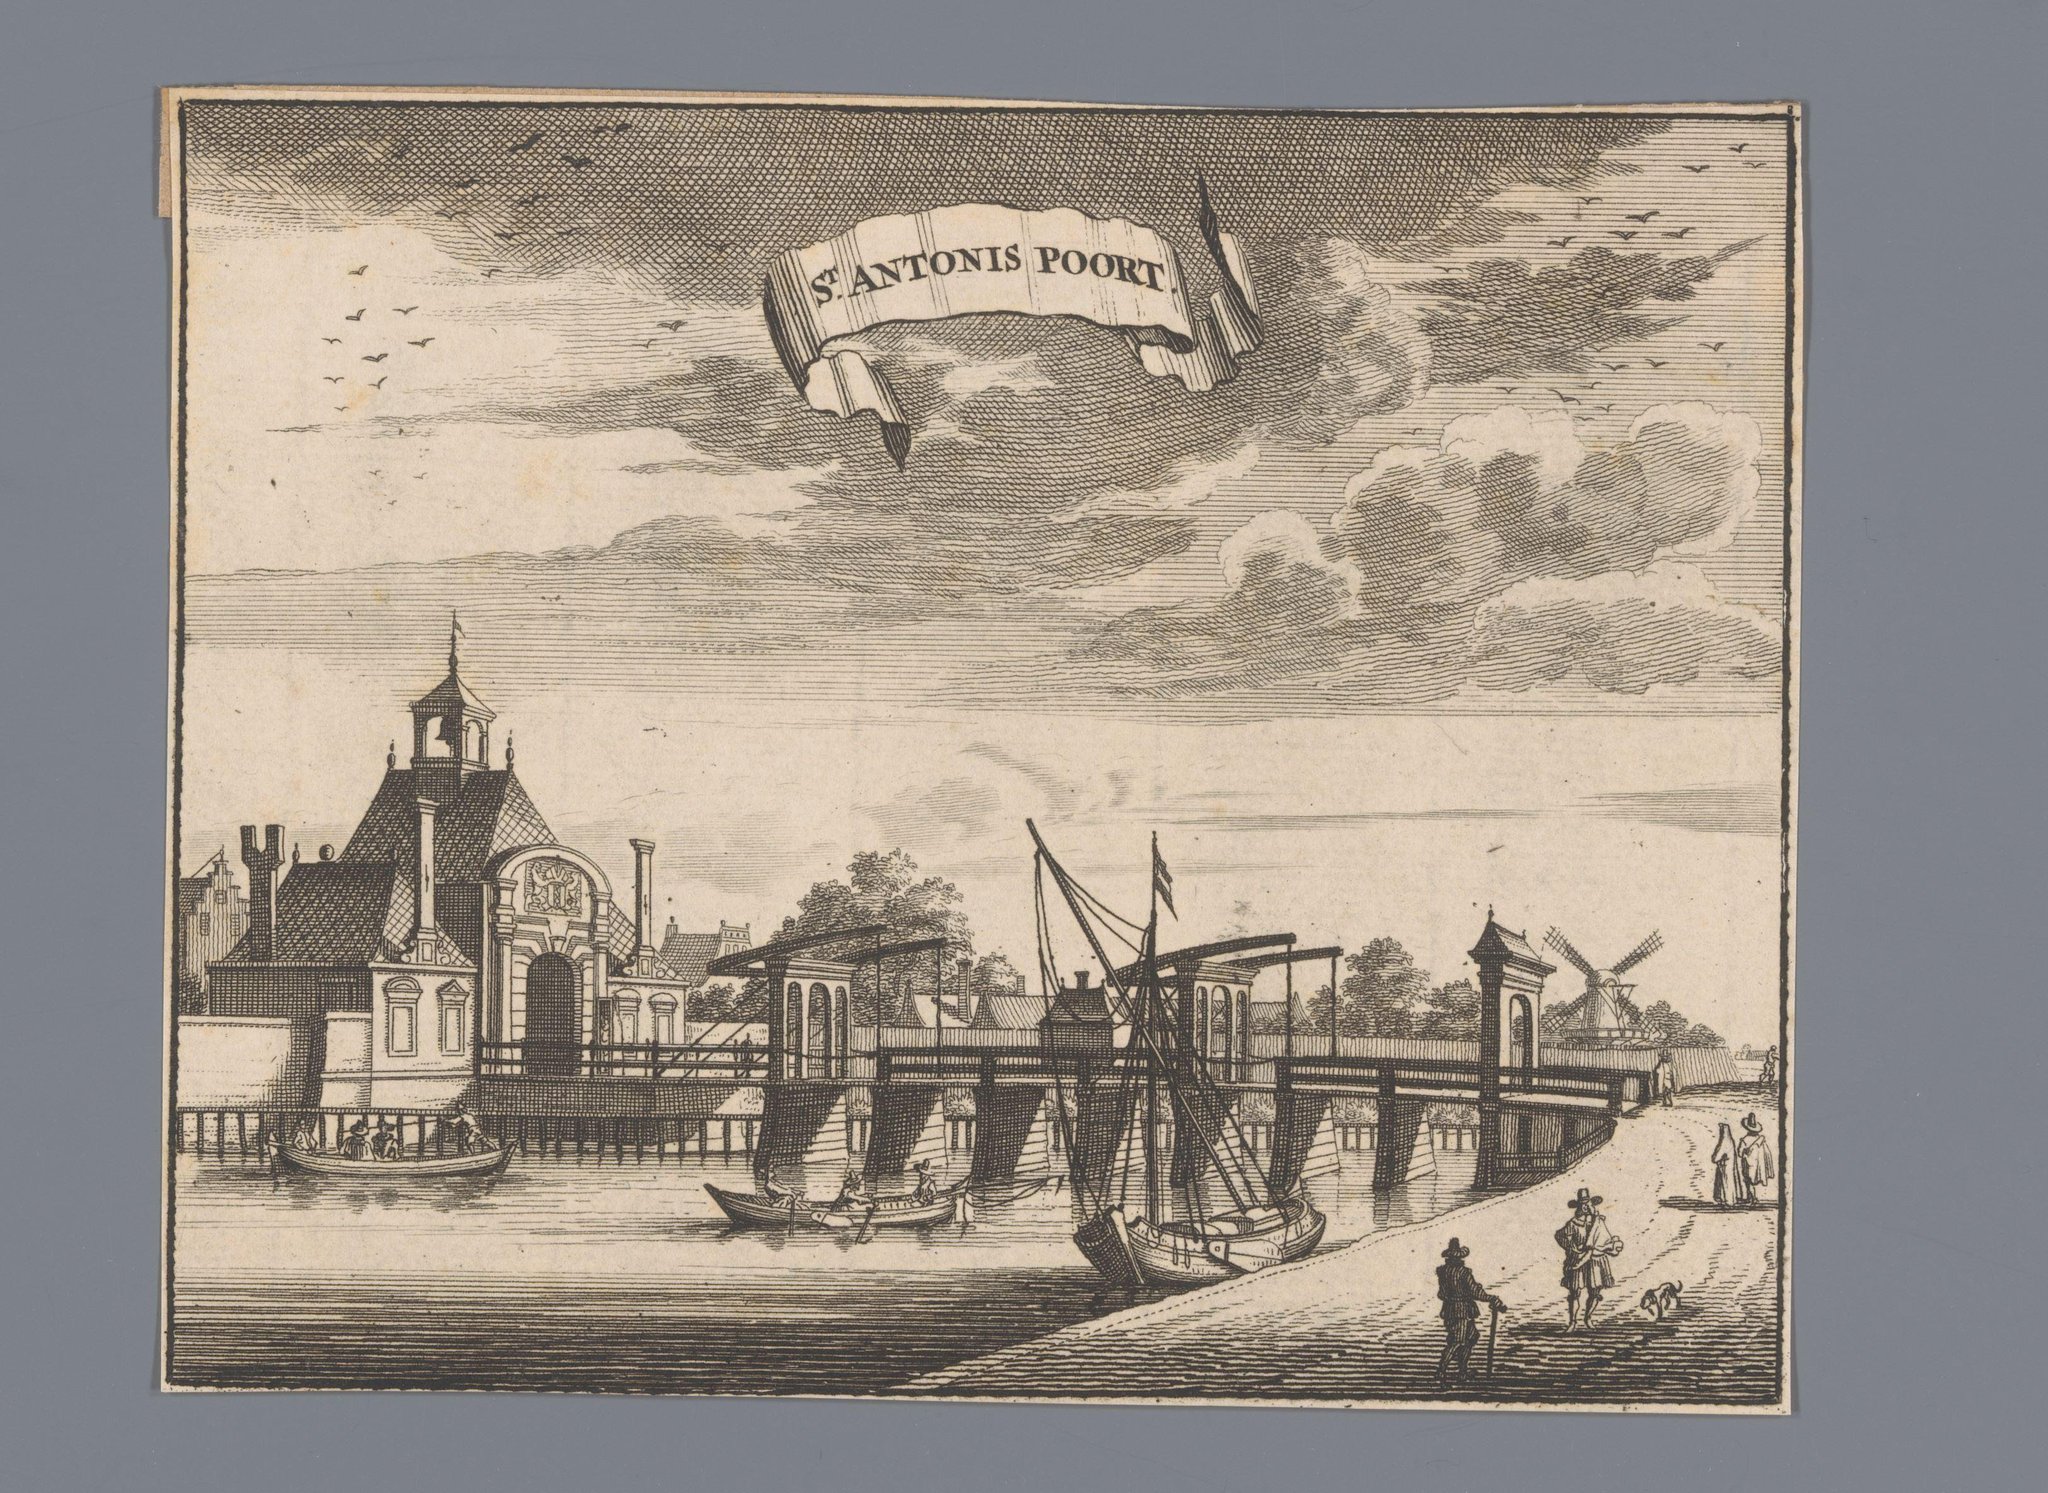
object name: print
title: St. Antonis poort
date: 1693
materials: paper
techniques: engraving, etching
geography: amsterdam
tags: sailing-ship, sailing-boat, rowing-boat, canoe, etc., bridge in city across river, canal, etc., city-gate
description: Prent uit: Commelin, Caspar. Beschryvinge van Amsterdam (...). 2 dln. Amsterdam: Abraham Wolfgang et al., 1693, dl. 1, p. 234. Hoewel deze prent identiek is aan de prent in bovenstaande editie ontbreekt hier de tekst die op het verso gedrukt zou moeten zijn.